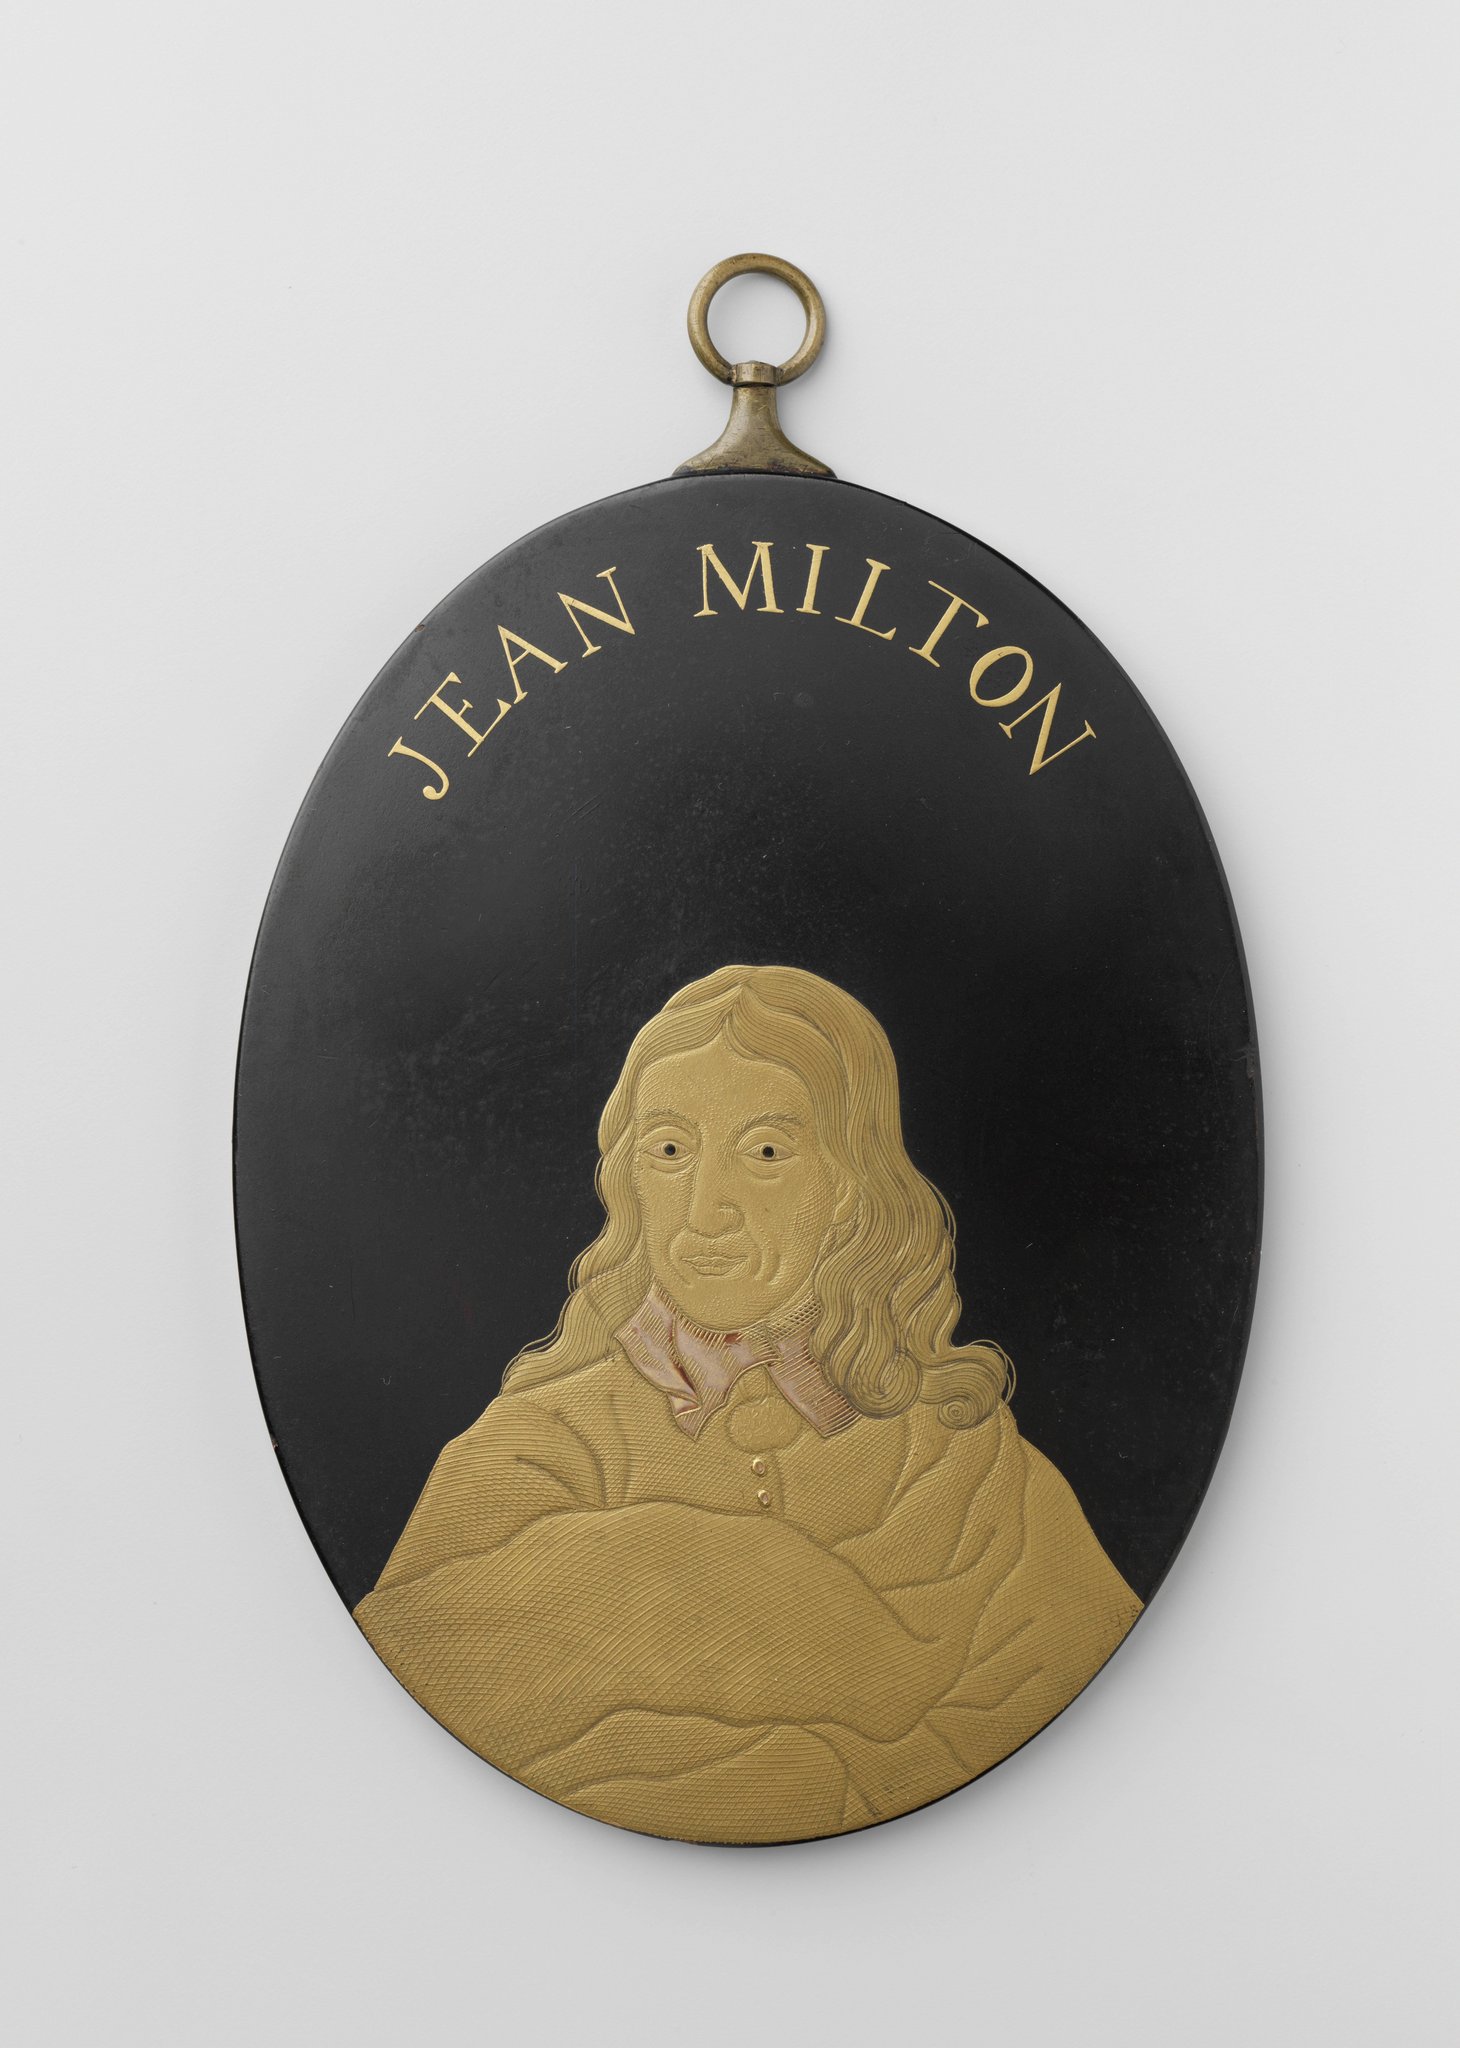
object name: plaque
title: Portret van John Milton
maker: Anonymous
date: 1775-1800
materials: copper, lacquer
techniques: lacquer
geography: japan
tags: john milton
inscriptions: mark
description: Portraits of European monarchs and scholars. Japan, last quarter 18th century. The VOC exported lacquer products commissioned specifically for the European market. Working from European prints, Japanese craftsmen made series of portraits for the VOC.